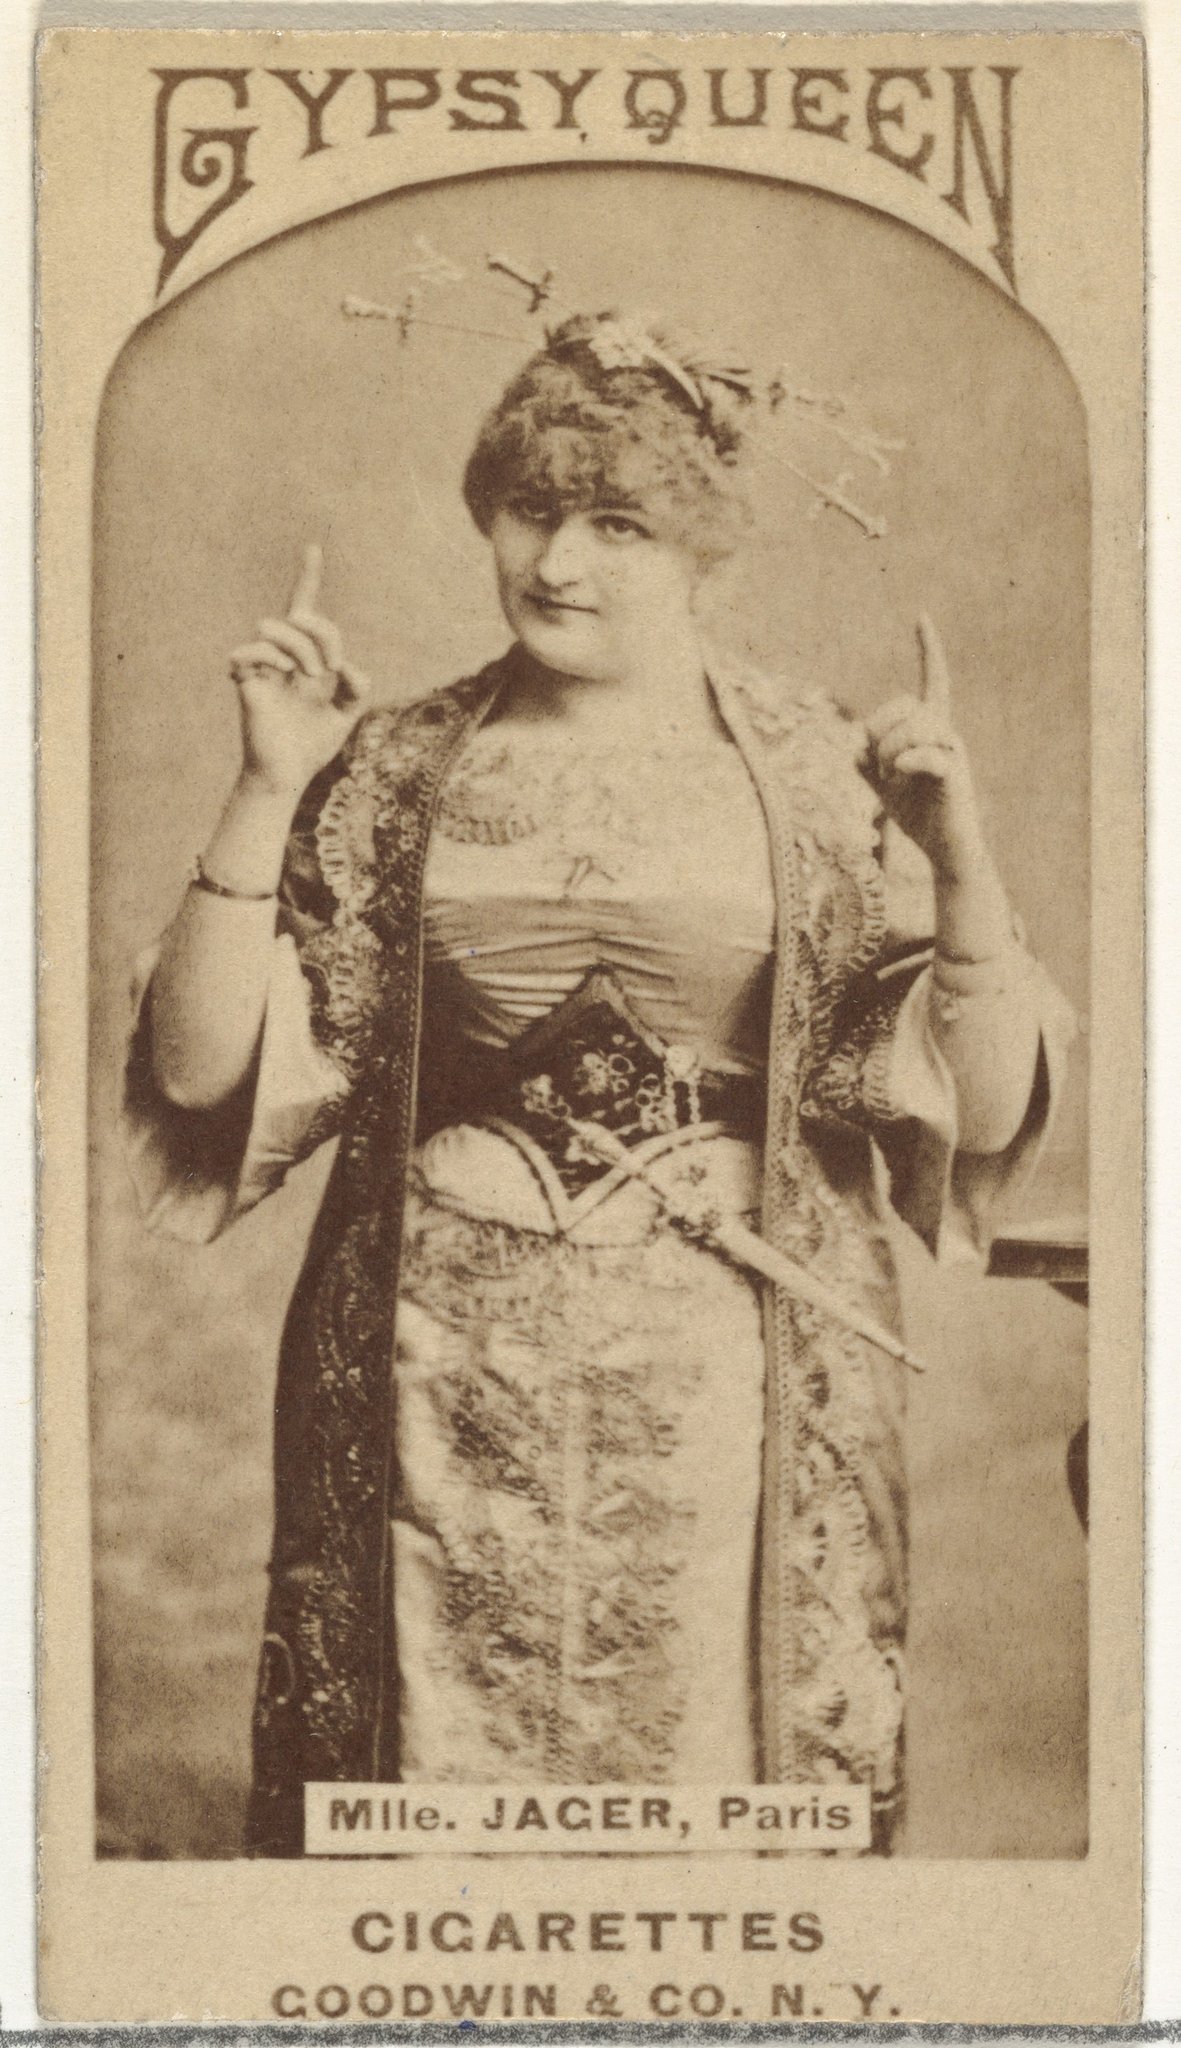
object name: photograph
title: Mlle. Jager, Paris, from the Actors and Actresses series (N171) for Gypsy Queen Cigarettes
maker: goodwin & company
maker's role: publisher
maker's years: 1850-1950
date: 1886-1890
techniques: albumen silver print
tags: portraits,women,actresses